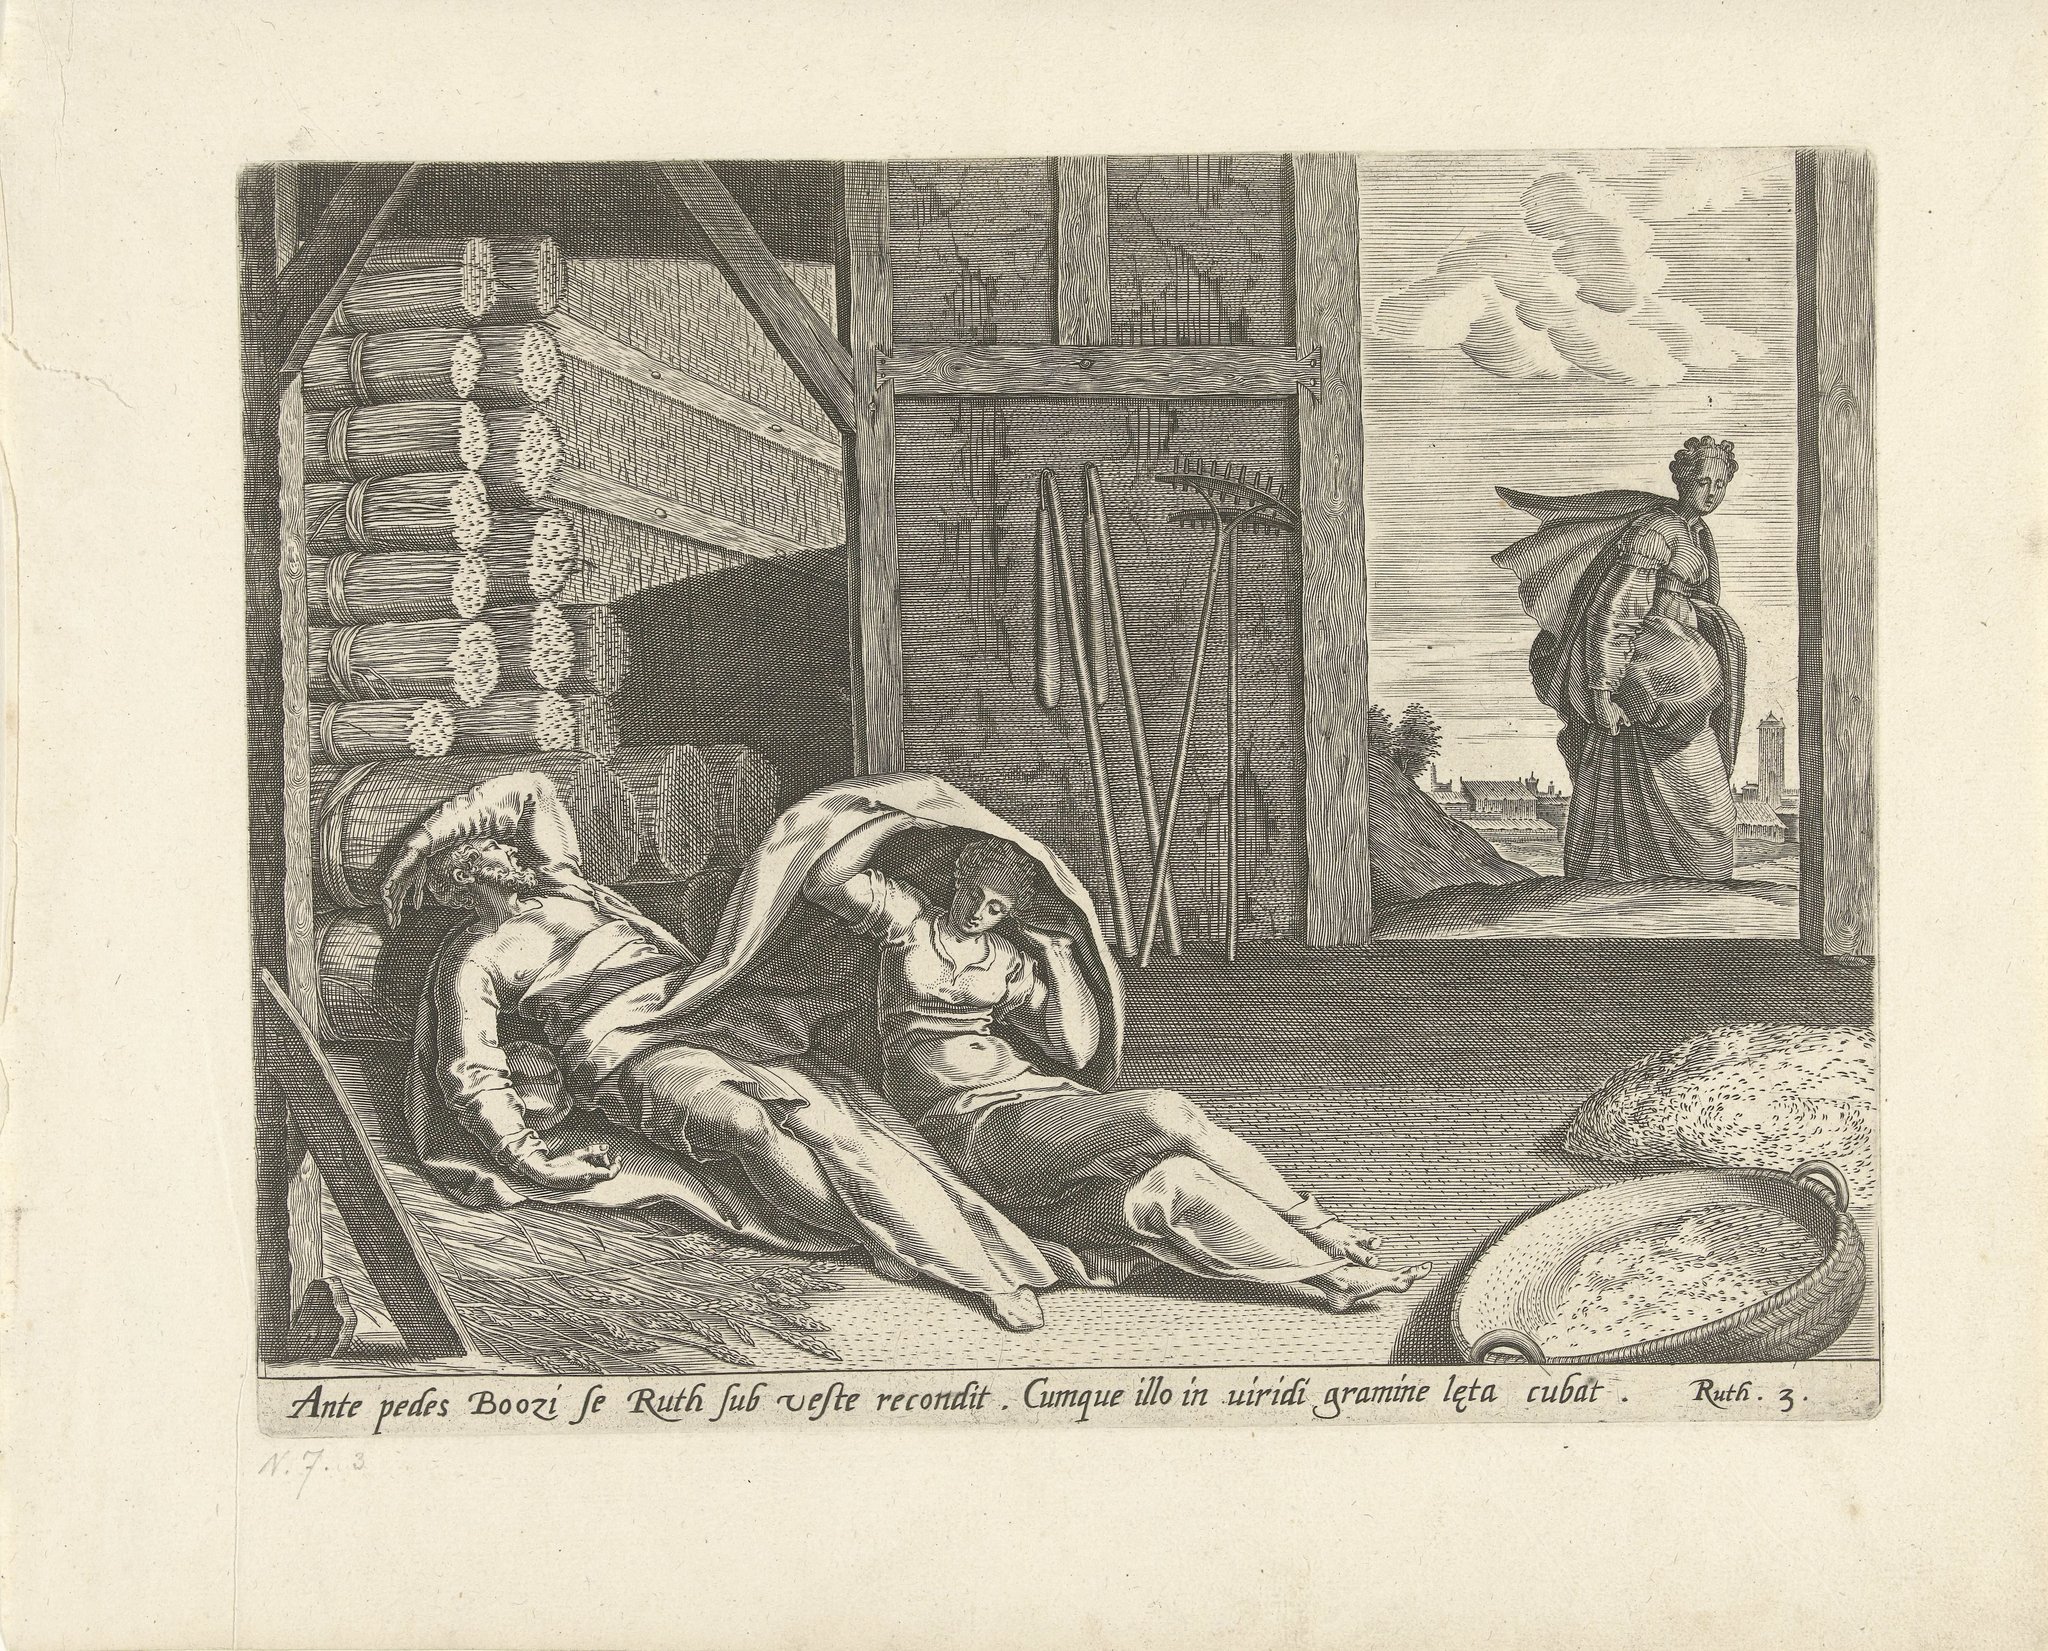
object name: print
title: Geschiedenis van Ruth en Boaz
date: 1557-1591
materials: paper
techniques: engraving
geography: antwerp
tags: ruth uncovers the feet of the sleeping boaz and lies down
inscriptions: collector's mark: Lugt 2228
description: Boaz slaapt in een korenschuur. Ruth gaat 's nachts aan zijn voeteneinde liggen. In het ochtendgloren verlaat ze de schuur weer.